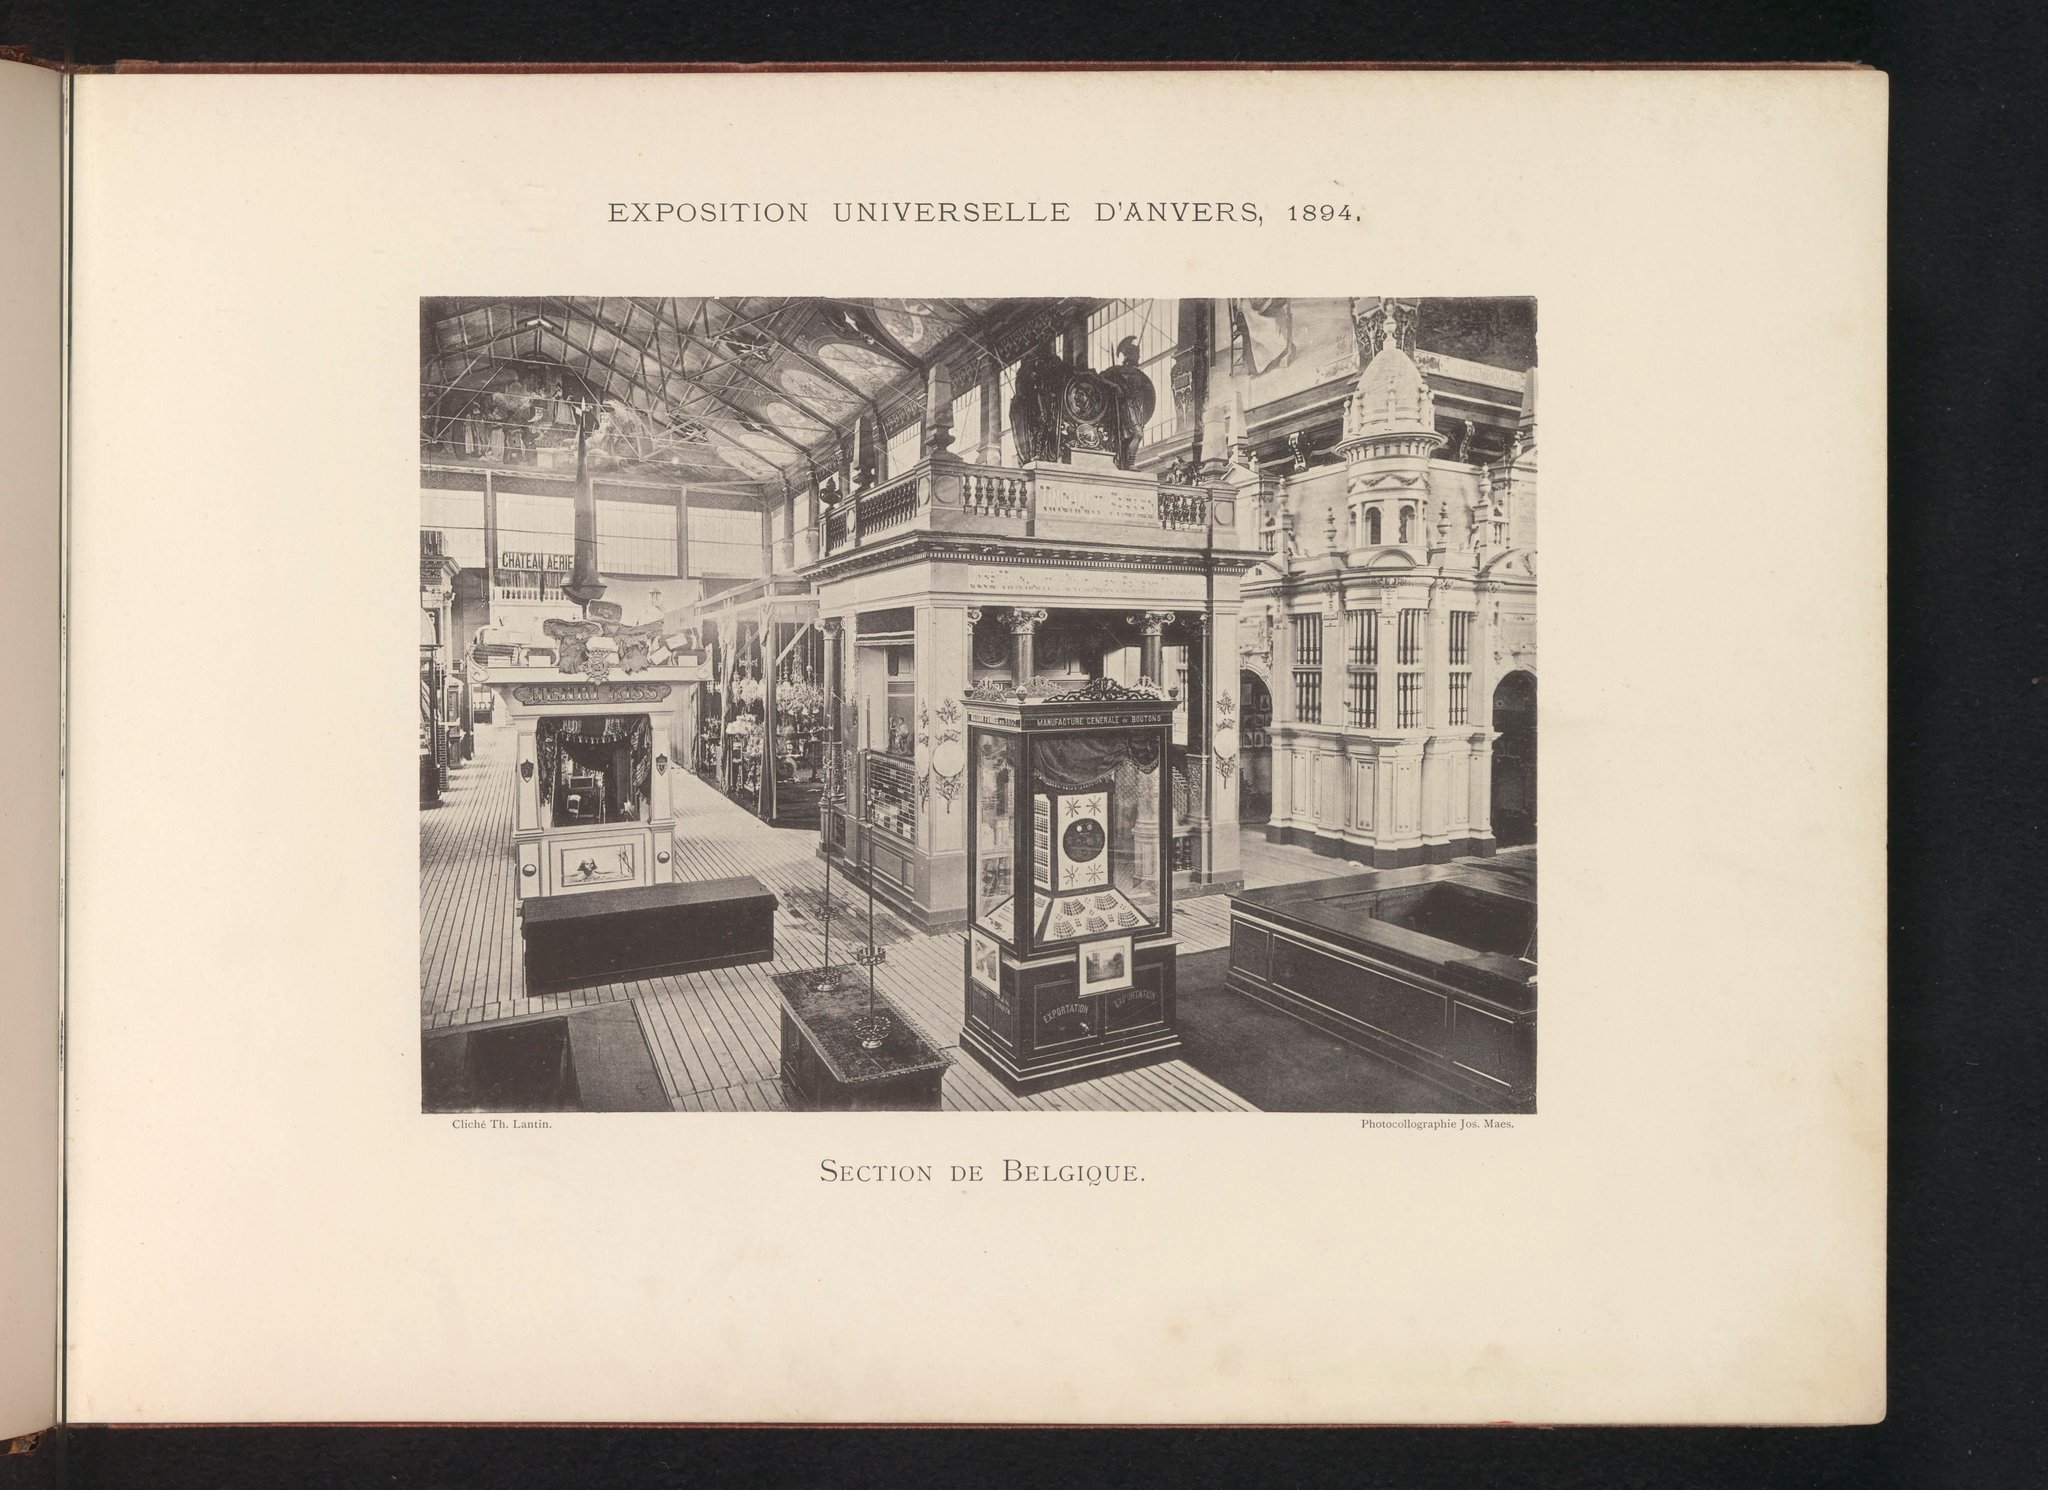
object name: photomechanical print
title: Section de Belgique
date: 1894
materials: paper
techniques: photograph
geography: antwerp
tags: world fair, world exhibition, collection, exhibition, show